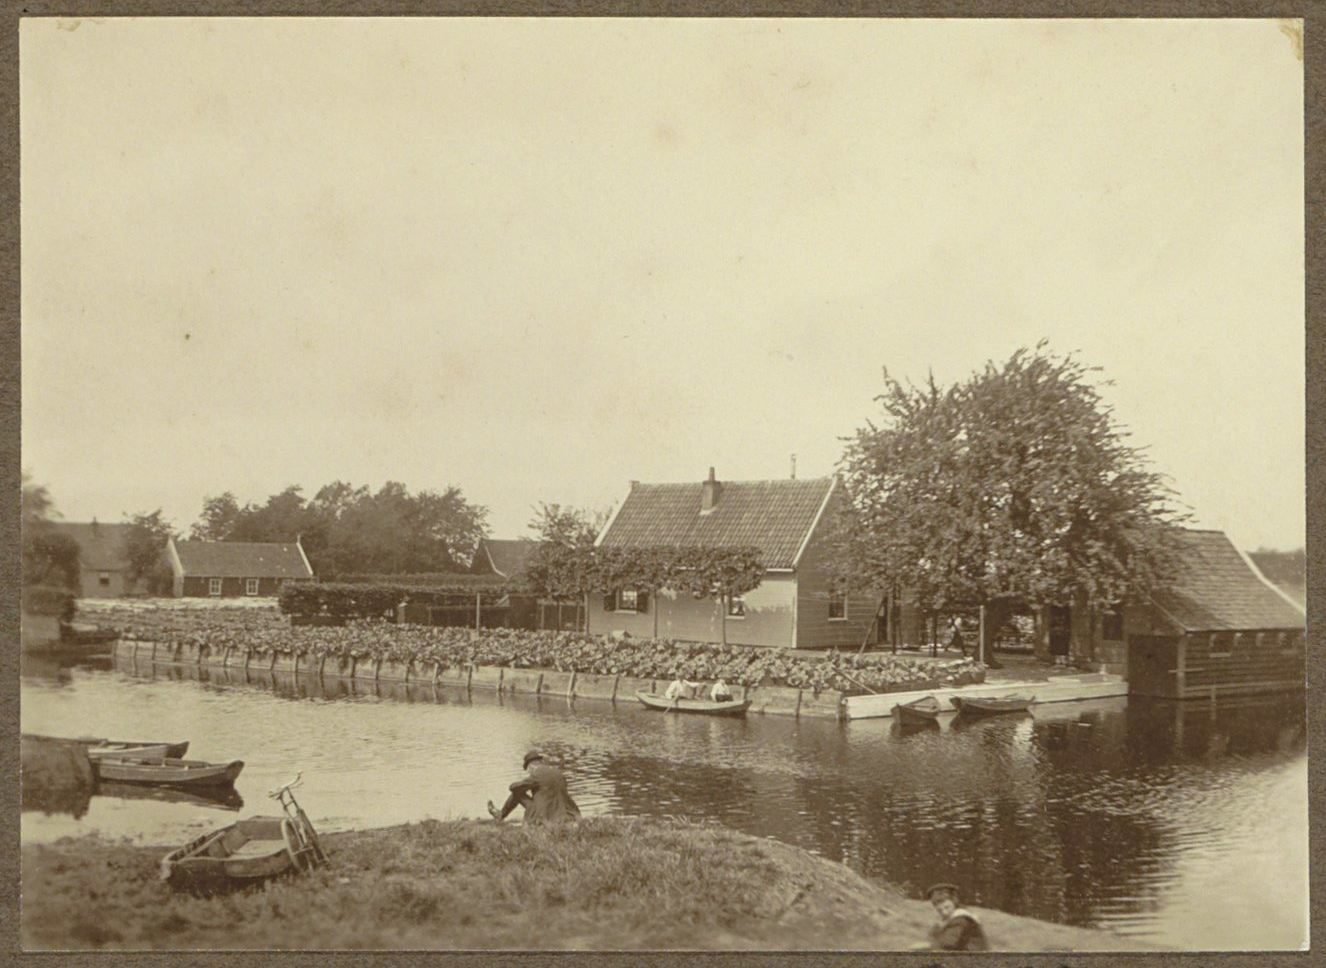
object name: photograph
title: Huizen aan het water achter de Andreas Schelfhoutstraat in Amsterdam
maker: Anonymous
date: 1910-1930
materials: paper, photographic support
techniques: gelatin silver print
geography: amsterdam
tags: small canal, ditch, amsterdam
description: Onderdeel van Album met foto's van Amsterdam en omgeving.